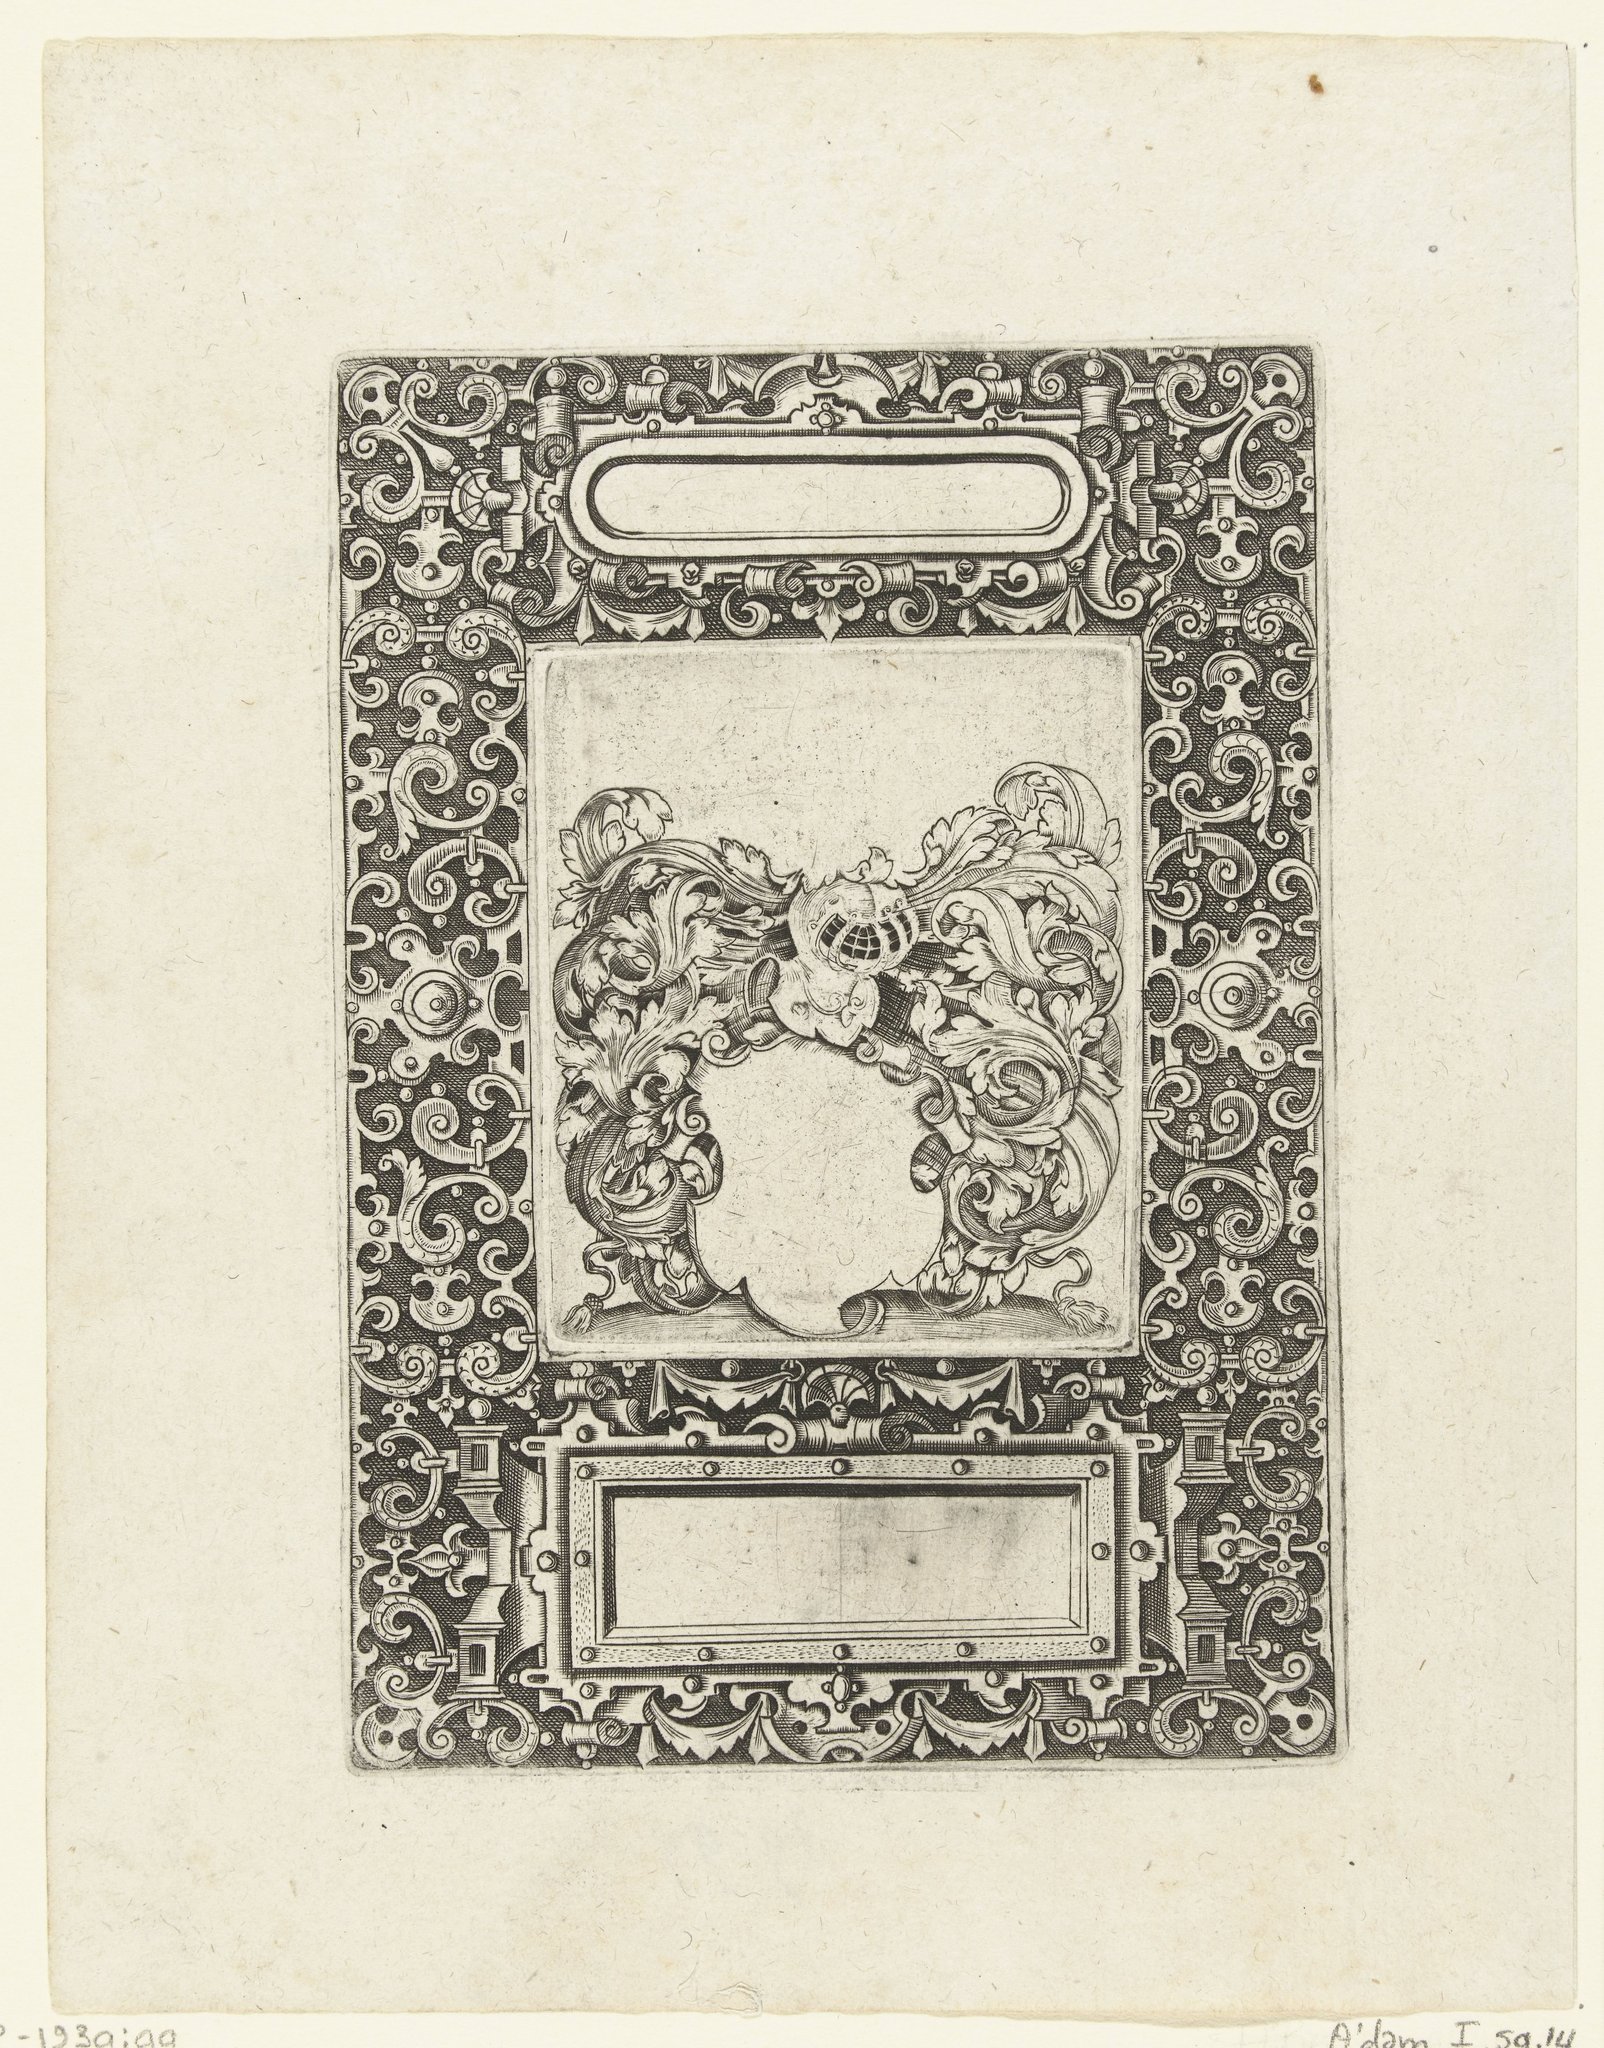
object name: print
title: Emblemata Nobilitati et Vulgo scitu digna…/ Stam und Wapenbuchlein…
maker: theodor de bry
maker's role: draughtsman, print maker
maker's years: 1528-1598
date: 1593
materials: paper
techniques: engraving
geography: netherlands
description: Middenboven een smalle, langwerpige cartouche met ronde zijkanten. Middenonder een rechthoekige cartouche. Hoort bij een serie van 18 bladen waarbij in het midden van aparte platen zevenentwintig emblemata en vijfenveertig wapenschilden zijn gedrukt. De emblemata zijn ten dele genummerd A-D, 1-7 en 9-21. Drie bladen hebben geen nummer. De wapenschilden, die deels dubbel zijn afgedrukt, zijn ongenummerd.